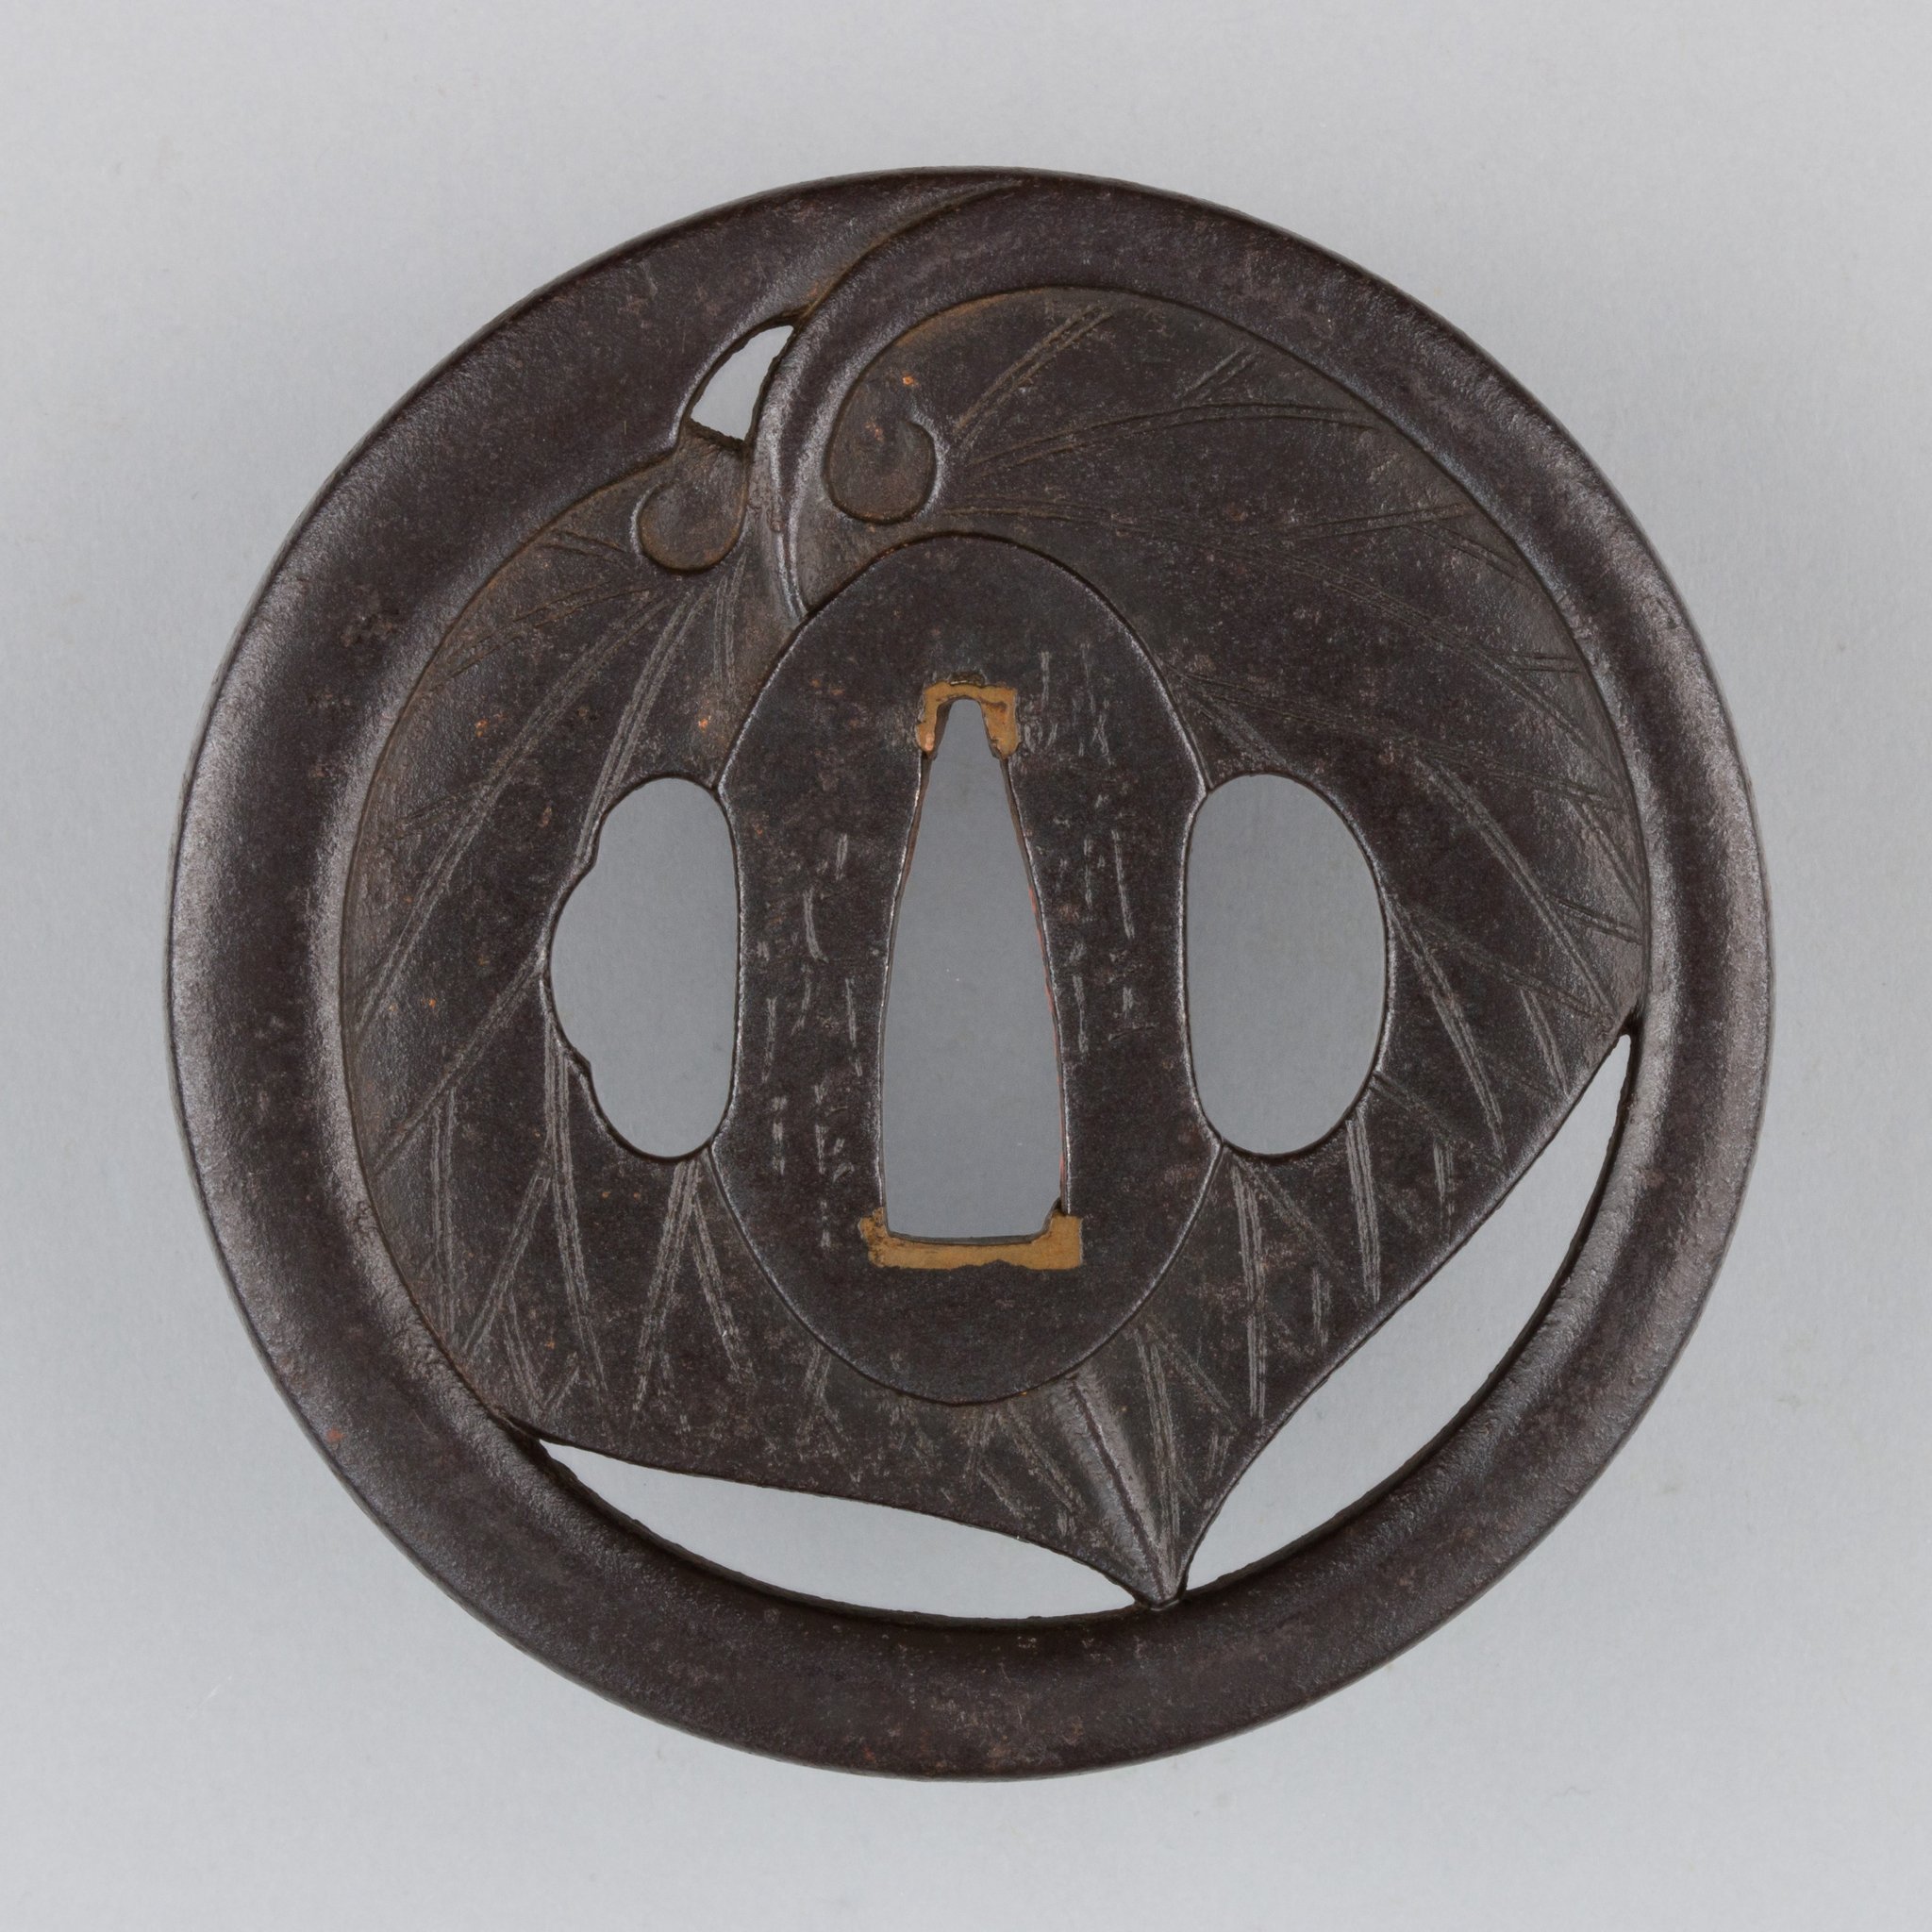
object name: sword guard tsuba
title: Sword Guard (Tsuba)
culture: japanese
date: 1701-1800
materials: copper, iron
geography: japan